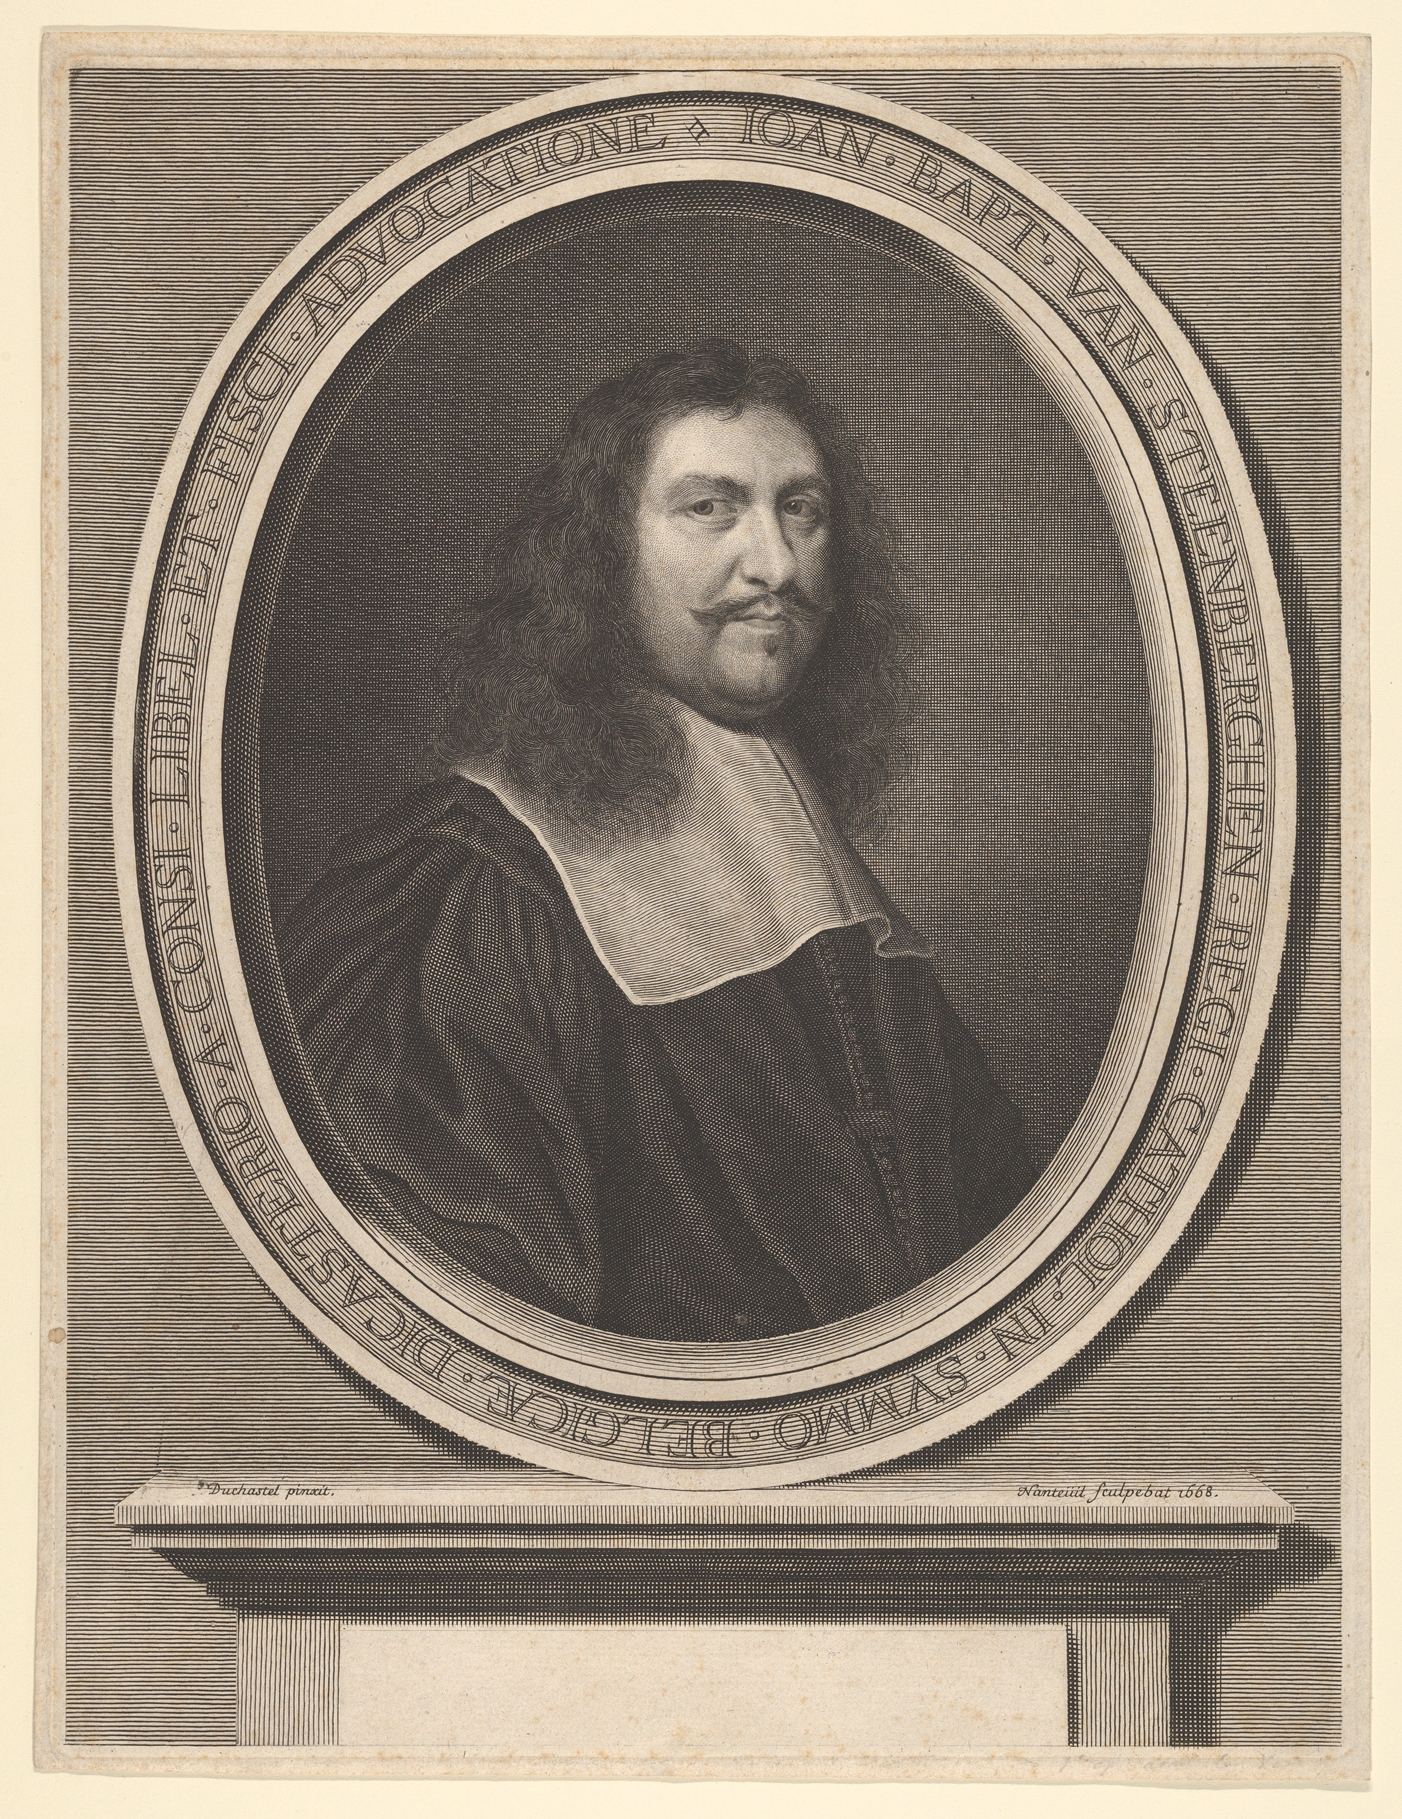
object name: print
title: Jean-Baptiste van Steenberghen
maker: robert nanteuil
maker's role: artist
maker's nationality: french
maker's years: 1623-1678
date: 1668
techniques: engraving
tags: men,portraits